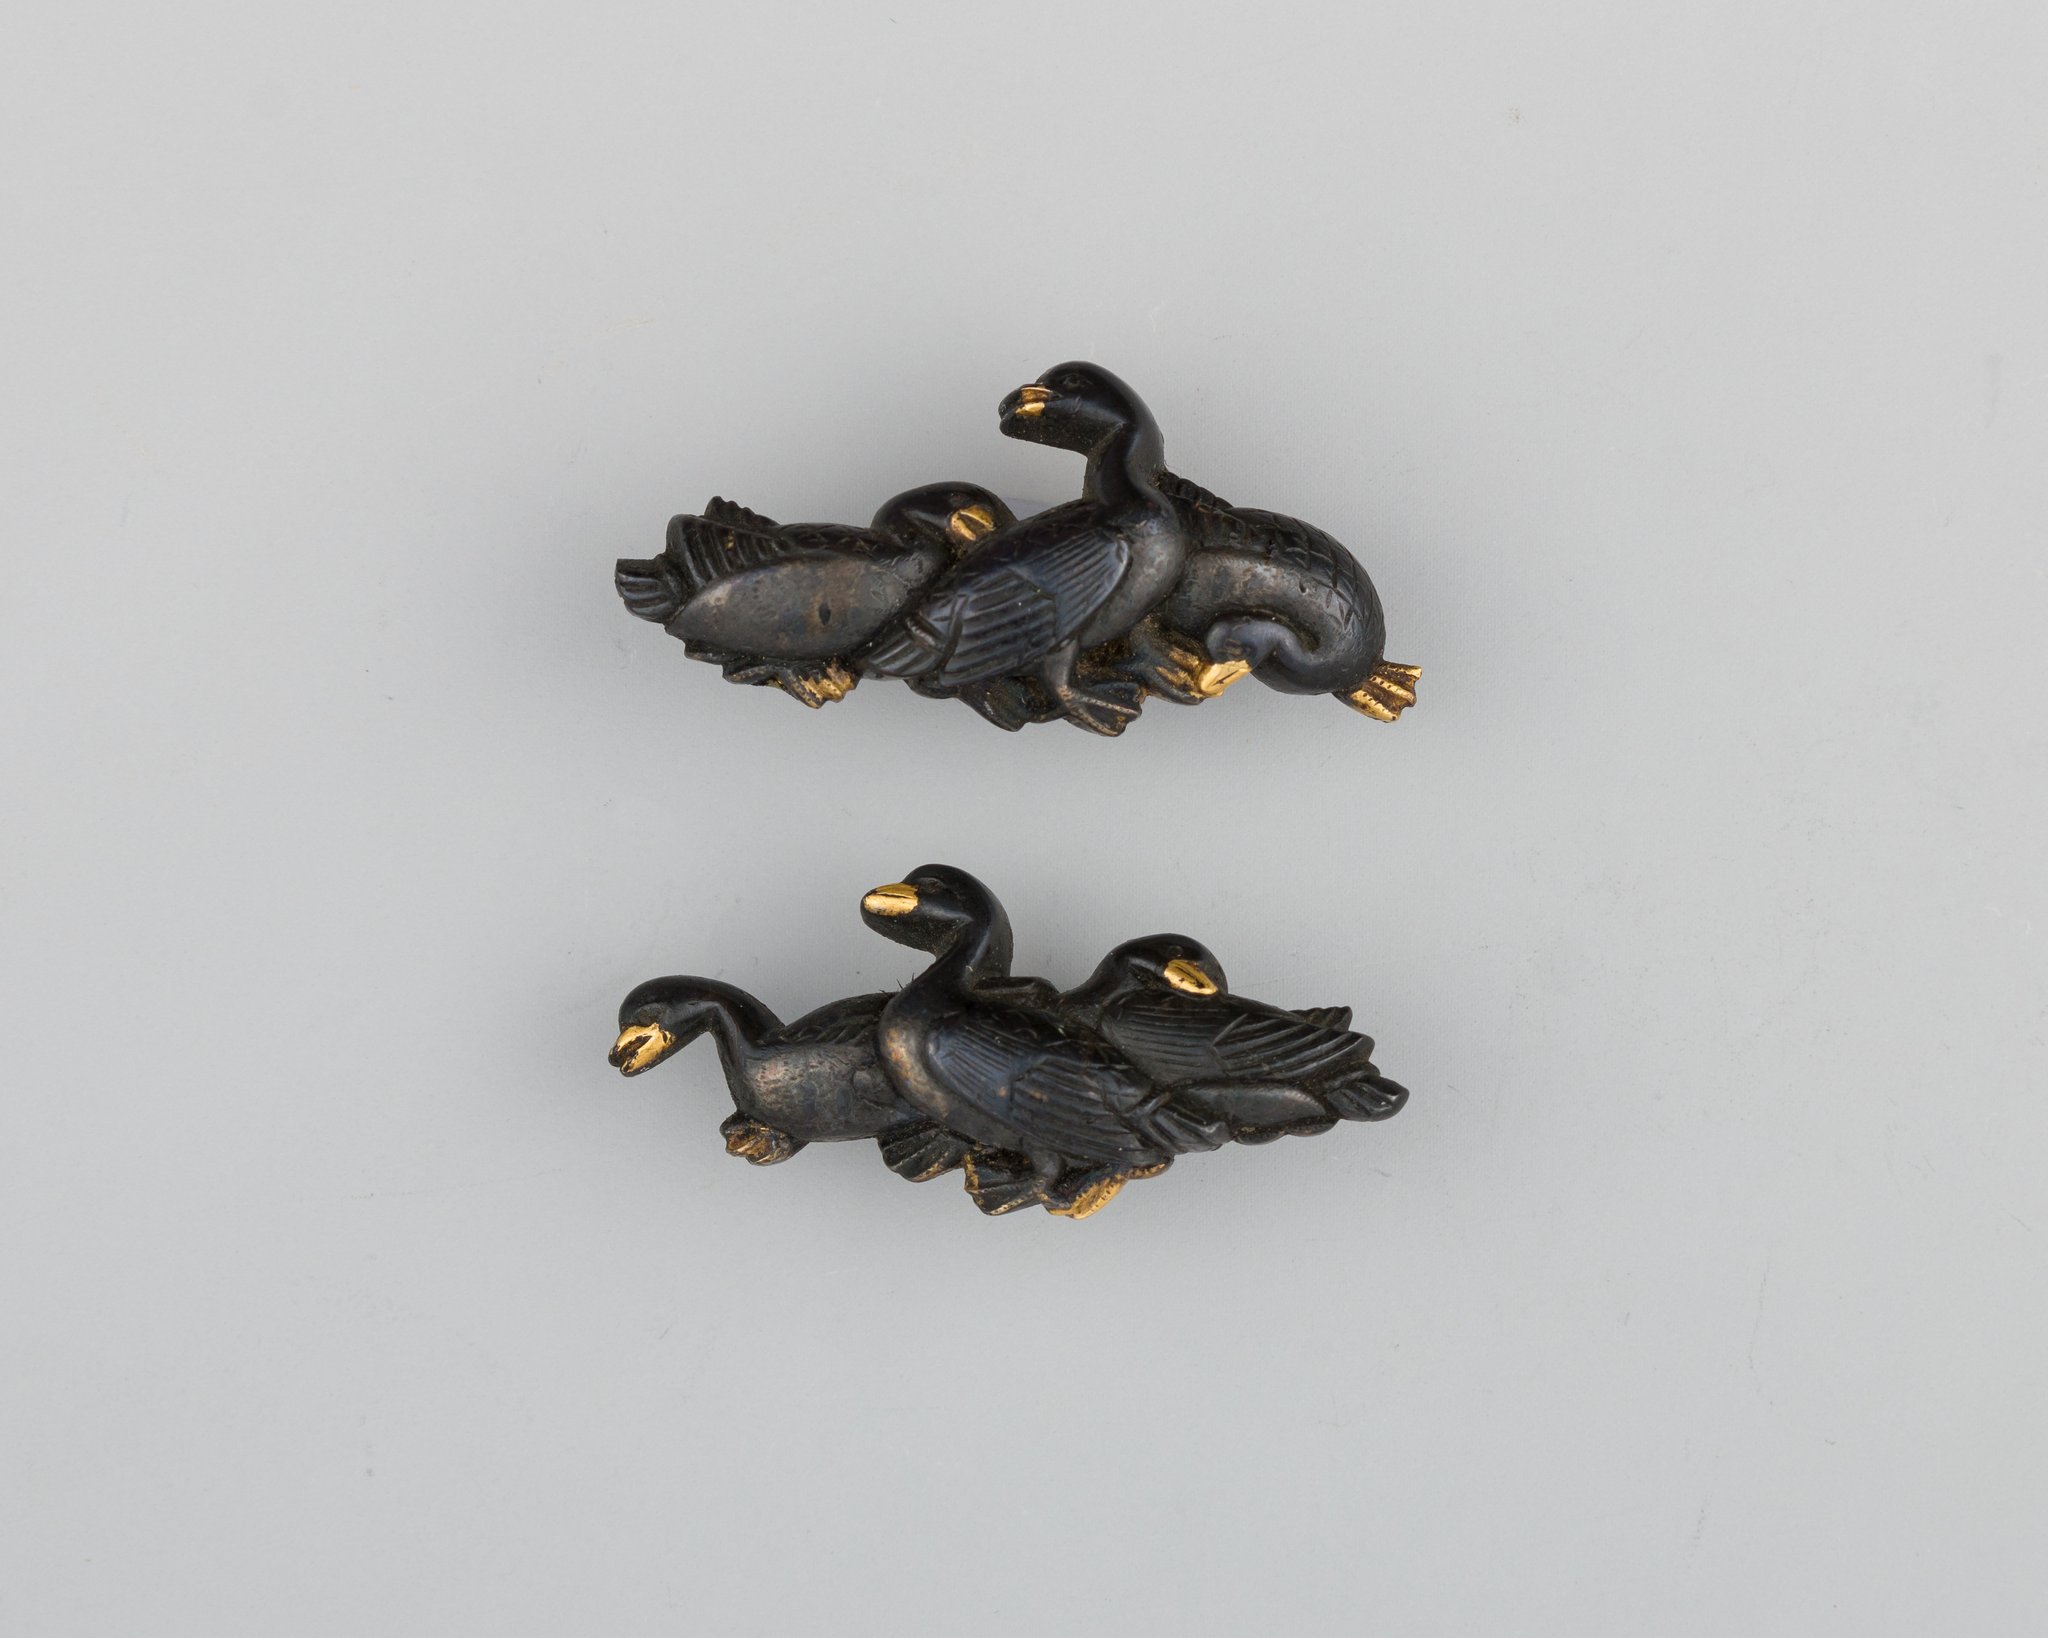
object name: pair of sword grip ornament menuki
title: Pair of Sword-Grip Ornaments (Menuki)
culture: japanese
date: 1701-1800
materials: gold alloy, silver alloy, gold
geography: japan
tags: ducks